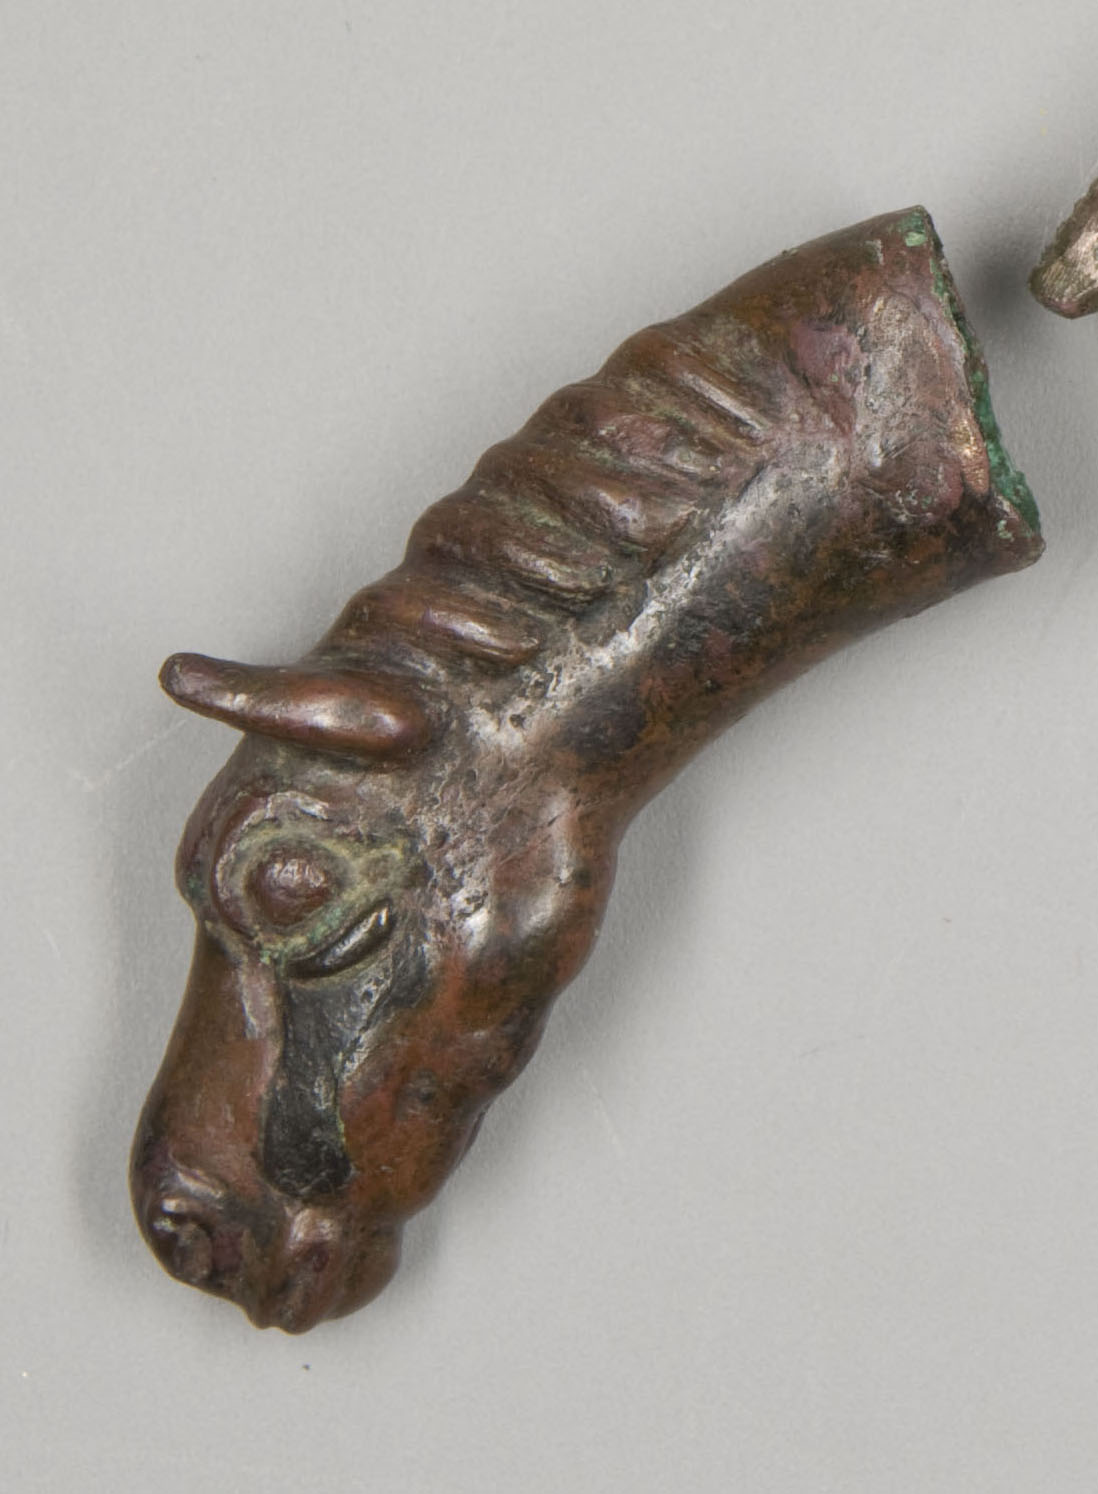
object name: axe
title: Axe head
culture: bactria-margiana archaeological complex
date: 2333-1668 BCE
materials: copper alloy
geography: bactria-margiana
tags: horses